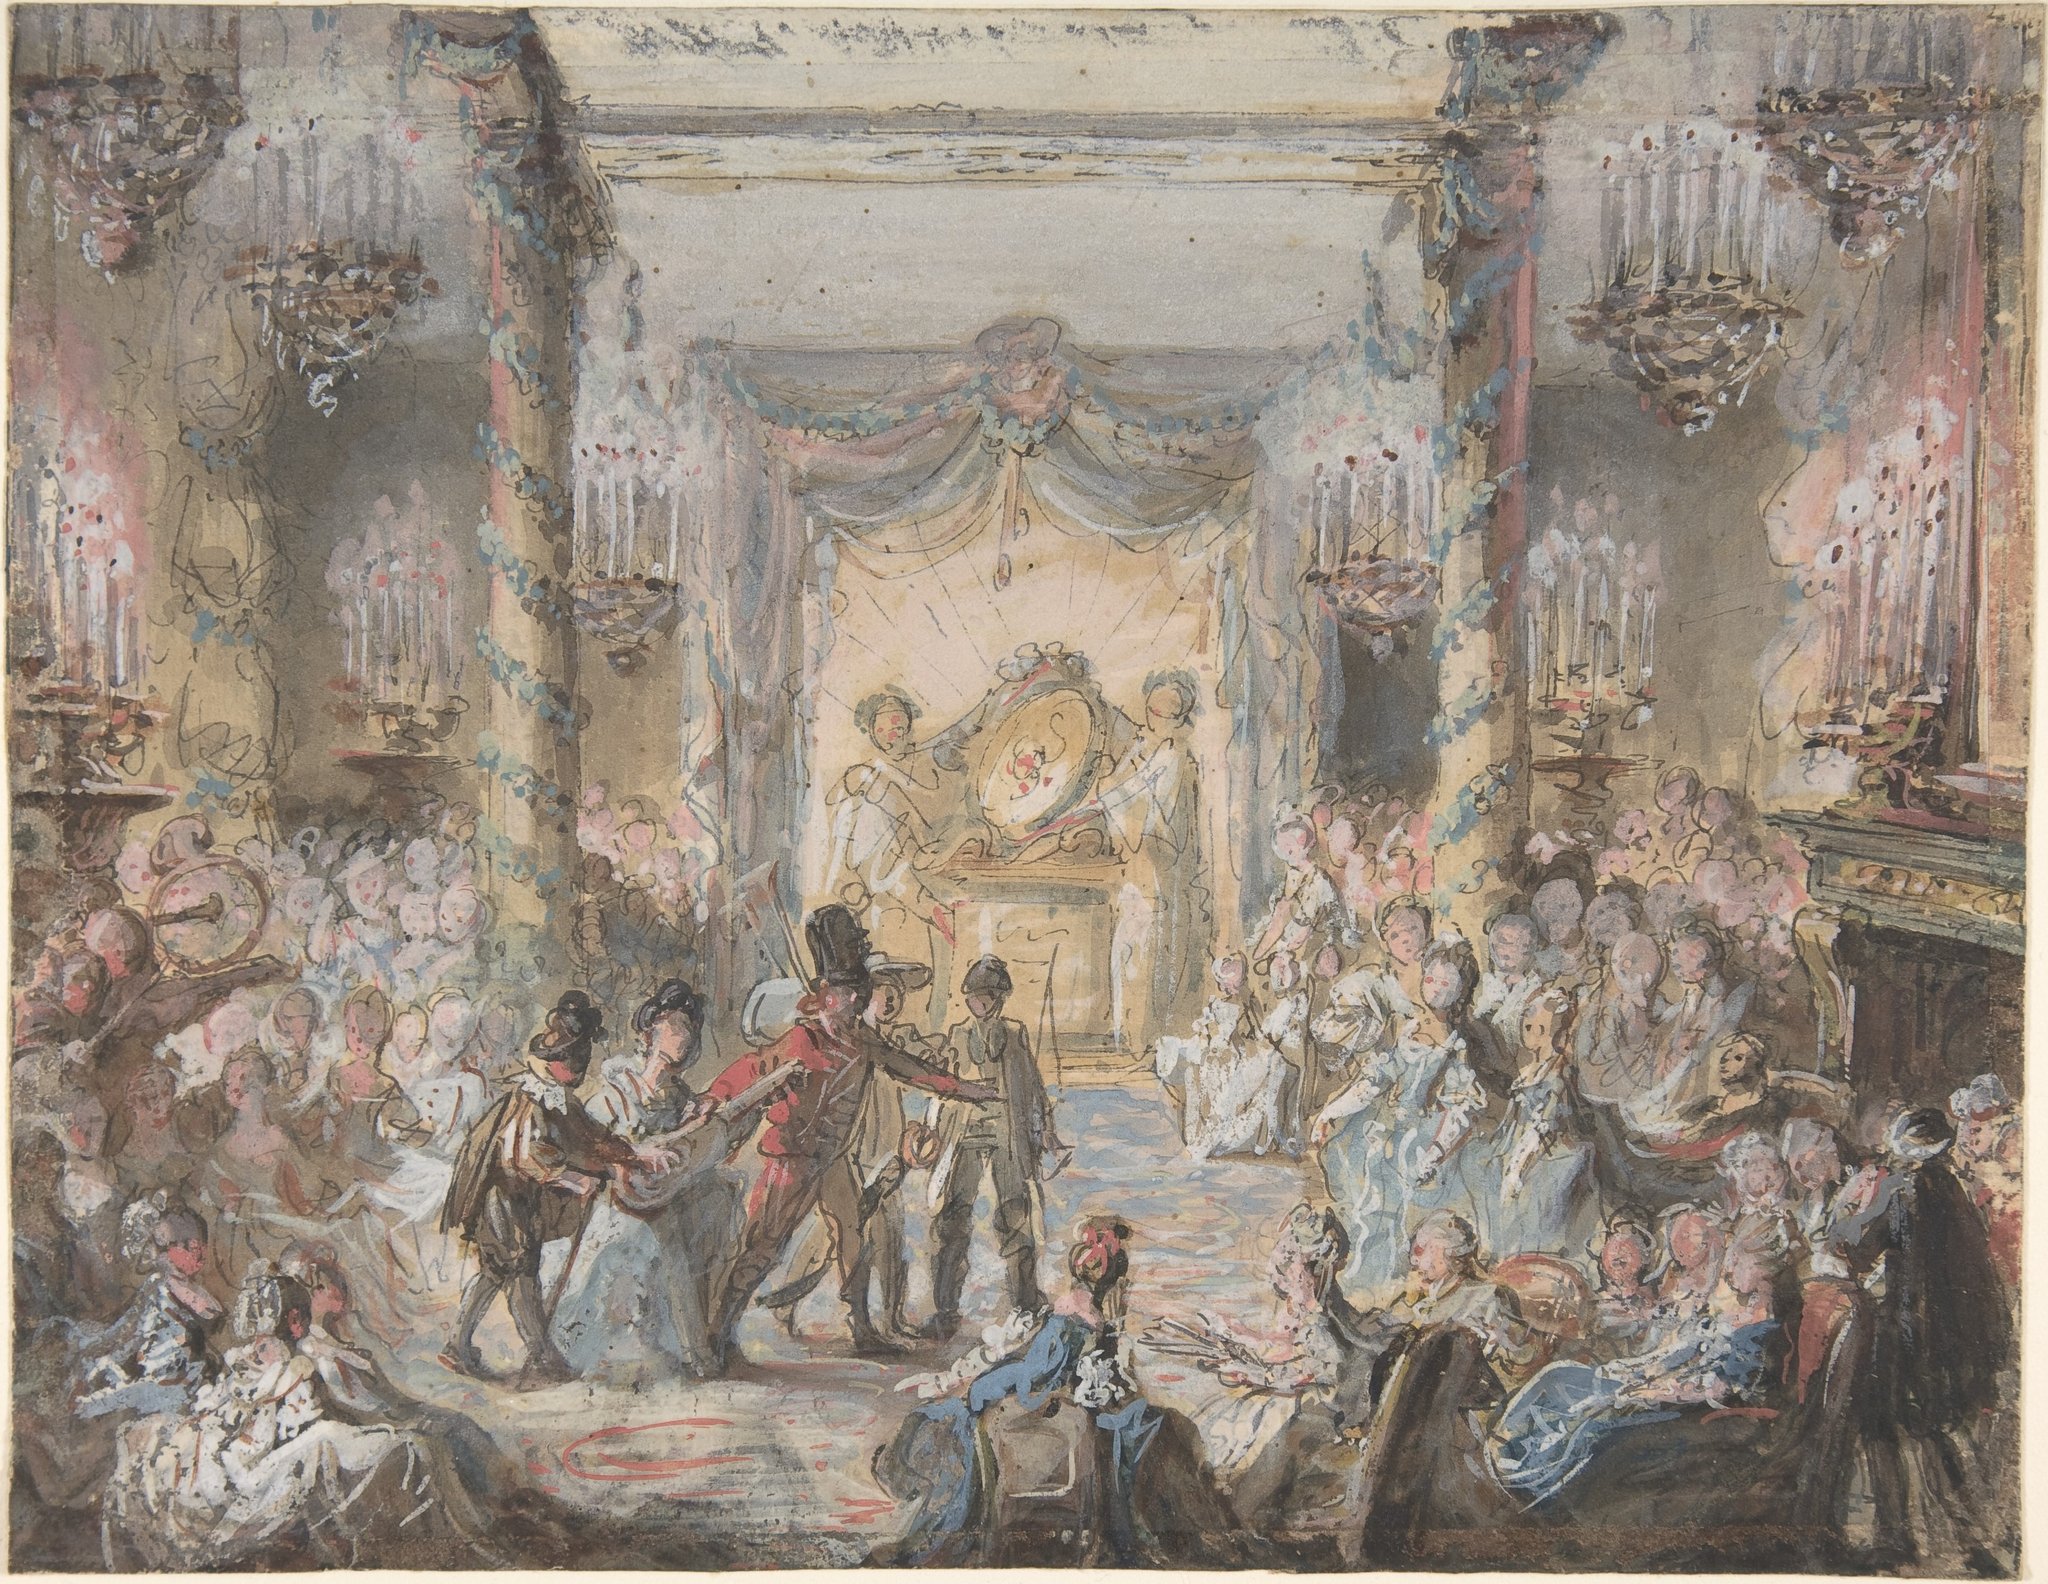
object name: drawing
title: Theatrical Divertissement at an Evening Party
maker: anonymous, french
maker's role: artist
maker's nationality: french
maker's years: 1400-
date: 1701-1800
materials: gouache, ink, watercolor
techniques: pen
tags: musical instruments,men,women,party